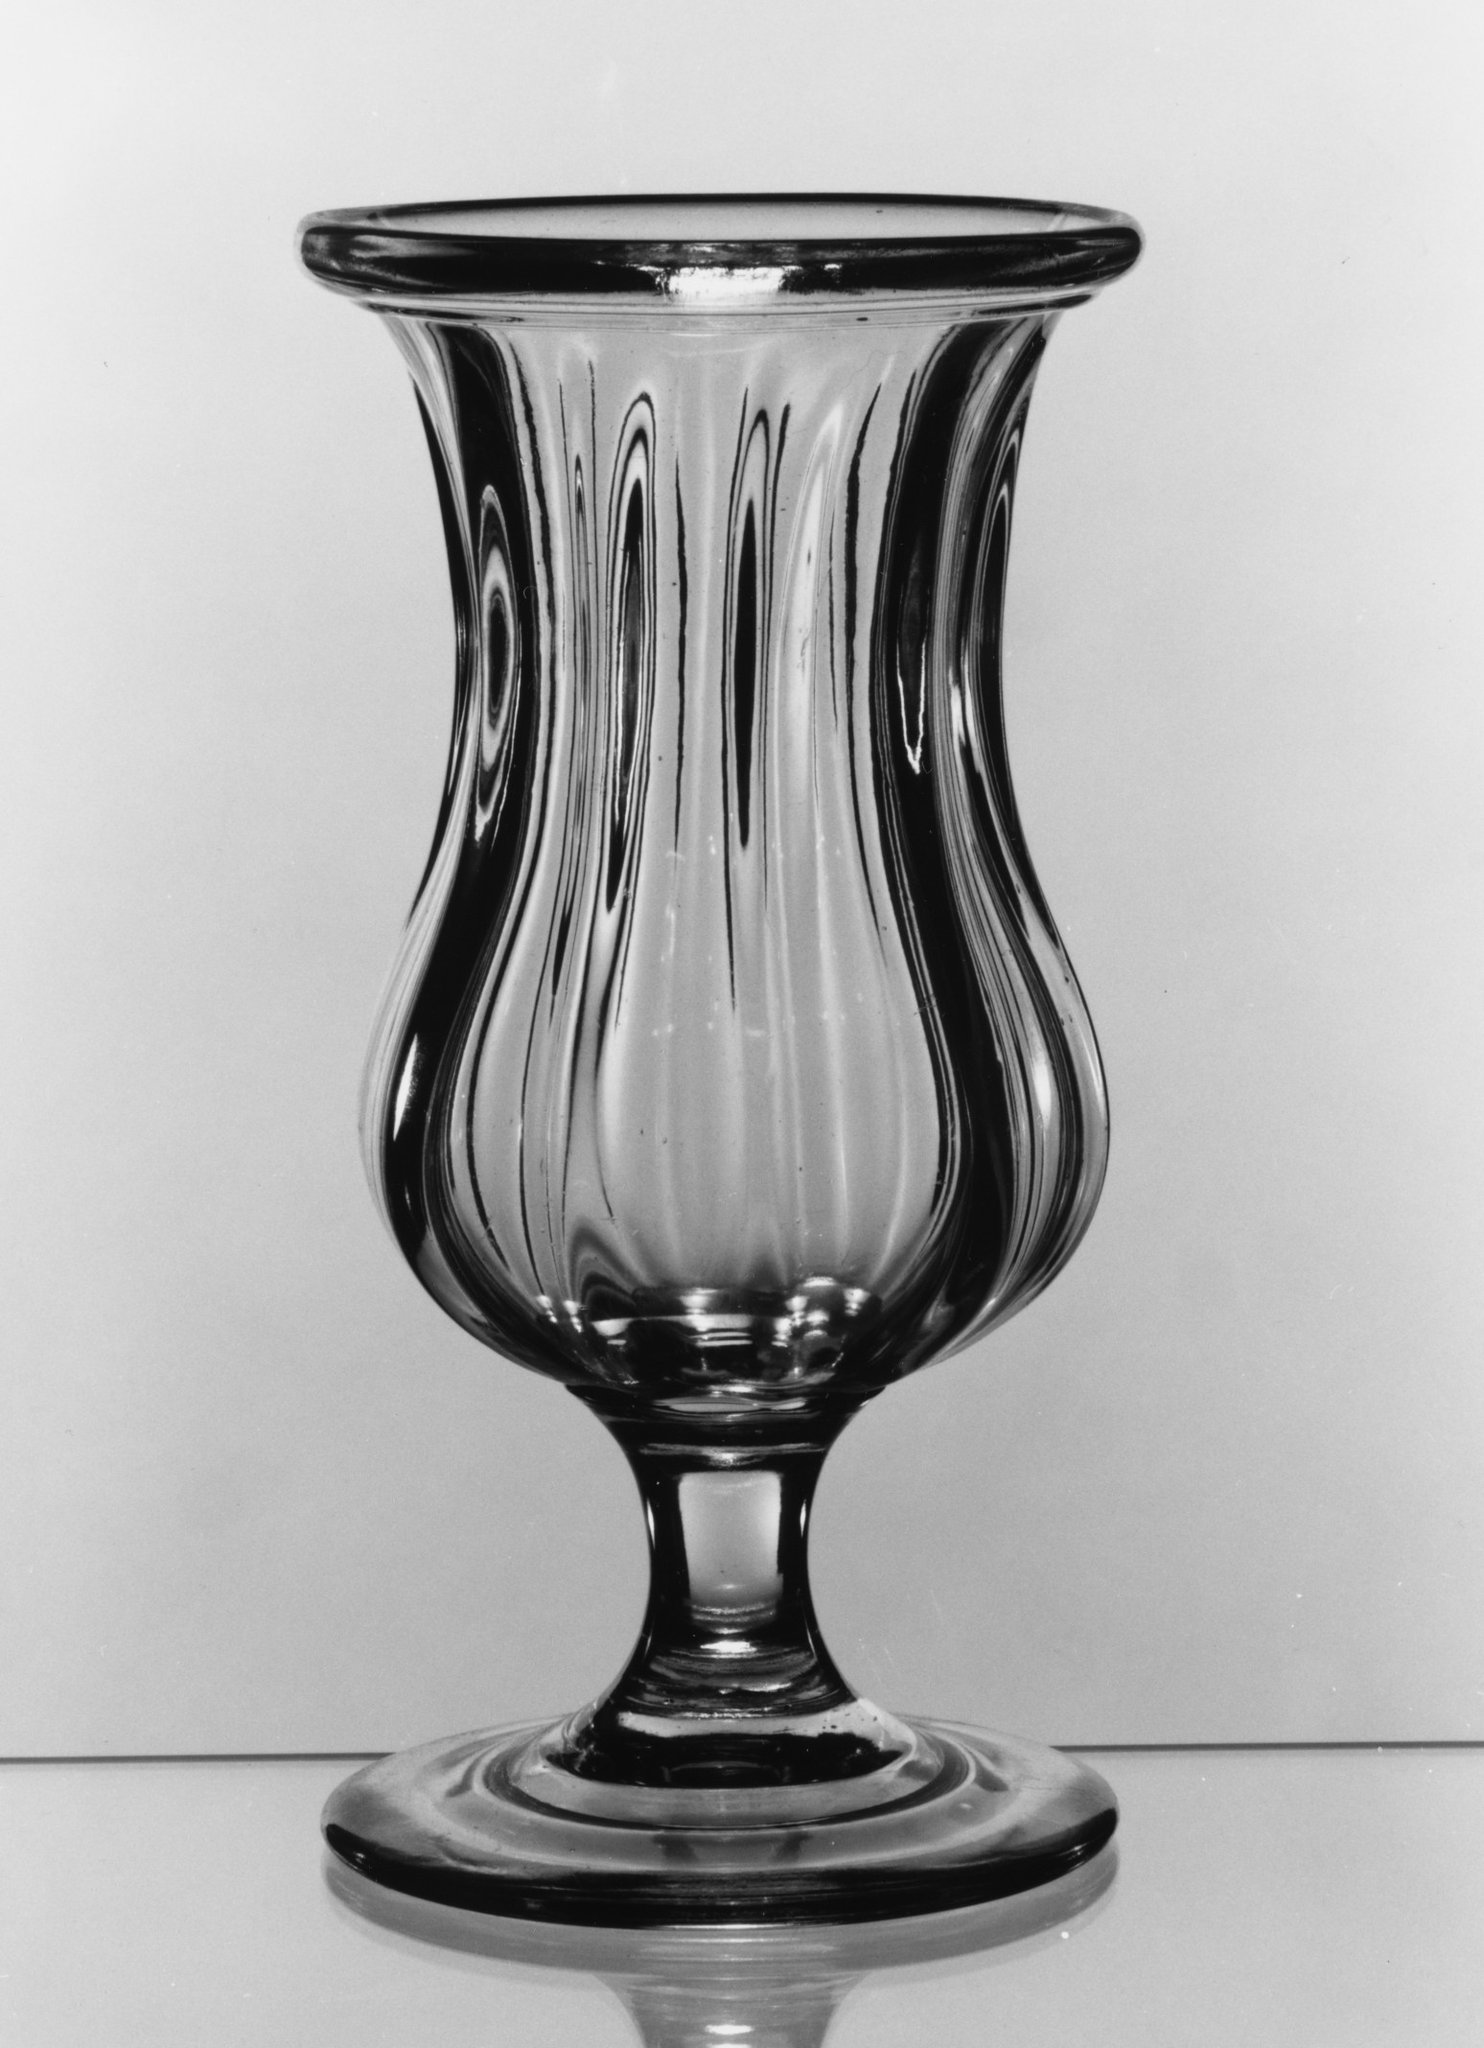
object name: celery vase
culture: american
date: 1850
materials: glass, lead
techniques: glassblowing, molding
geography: united states